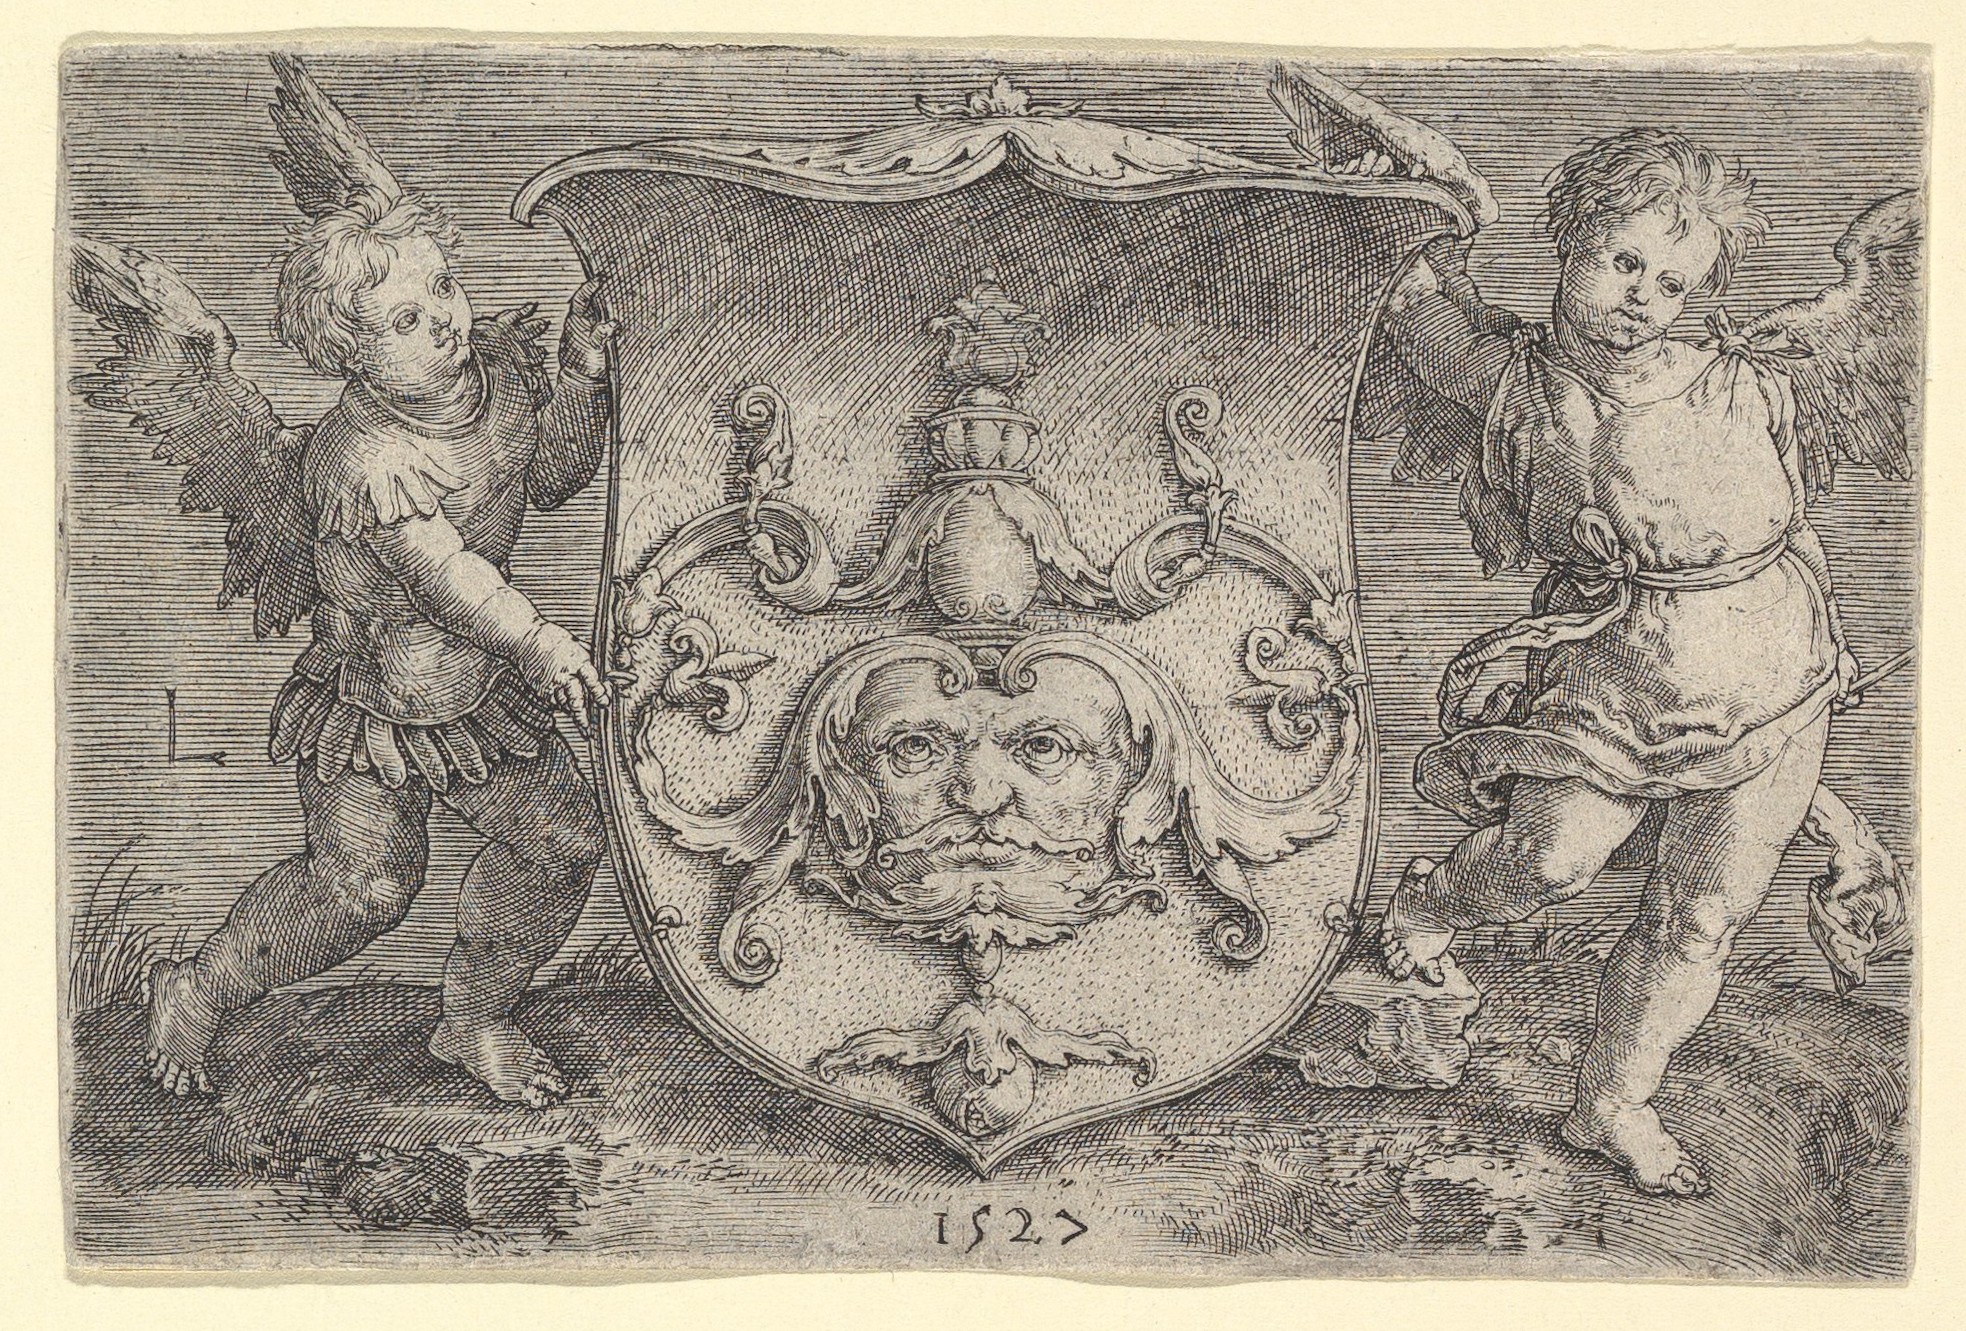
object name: print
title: Coat of Arms with a Mask, Held by Two Genii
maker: lucas van leyden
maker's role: artist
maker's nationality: netherlandish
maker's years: 1494-1533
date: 1527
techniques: engraving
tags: masks,coat of arms